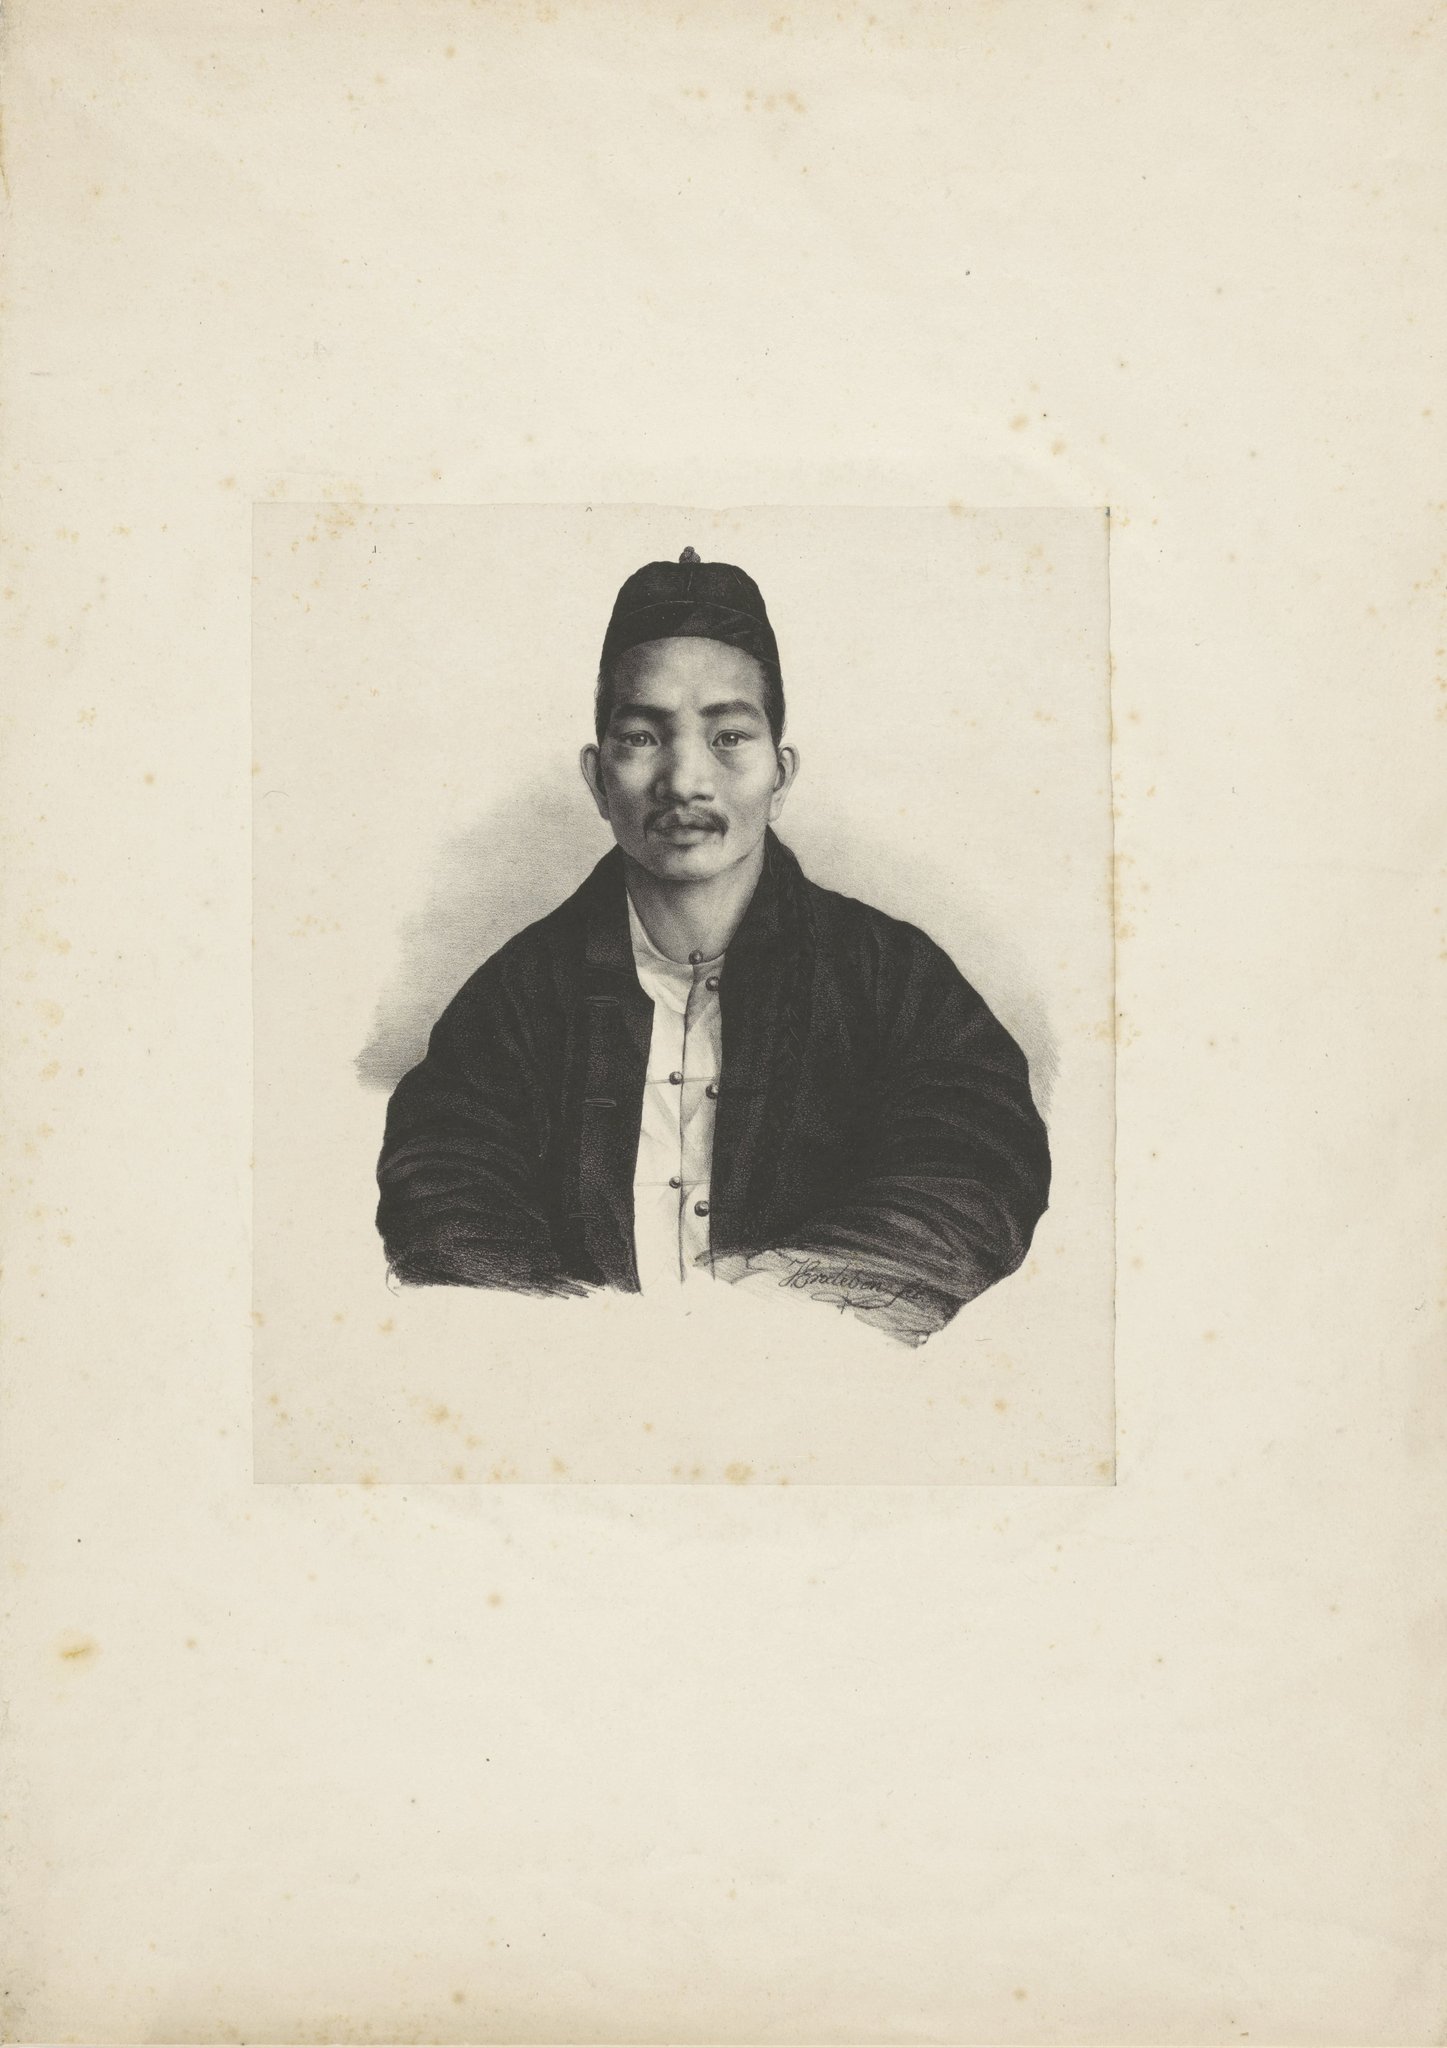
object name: print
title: Portrait of Guo Chengzhang (Ko Tsching Dschang)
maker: james erxleben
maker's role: print maker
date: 1801-1835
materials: paper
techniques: lithograph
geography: netherlands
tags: philipp franz von siebold, historical persons (+ (full) bust portrait)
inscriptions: collector's mark: Lugt 2228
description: In Batavia (now Jakarta), Philipp Franz von Siebold hired the Chinese writer Guo Chengzhang (1802–?) as a collaborator on Chinese-Japanese publications. Guo lived in Leiden from 1830 to 1835 and calligraphed two Chinese-Japanese dictionaries and texts in Von Siebold’s publication on Japan, Nippon. He was also the tutor of J.J. Hoffmann, professor of Chinese and Japanese at Leiden University from 1855.